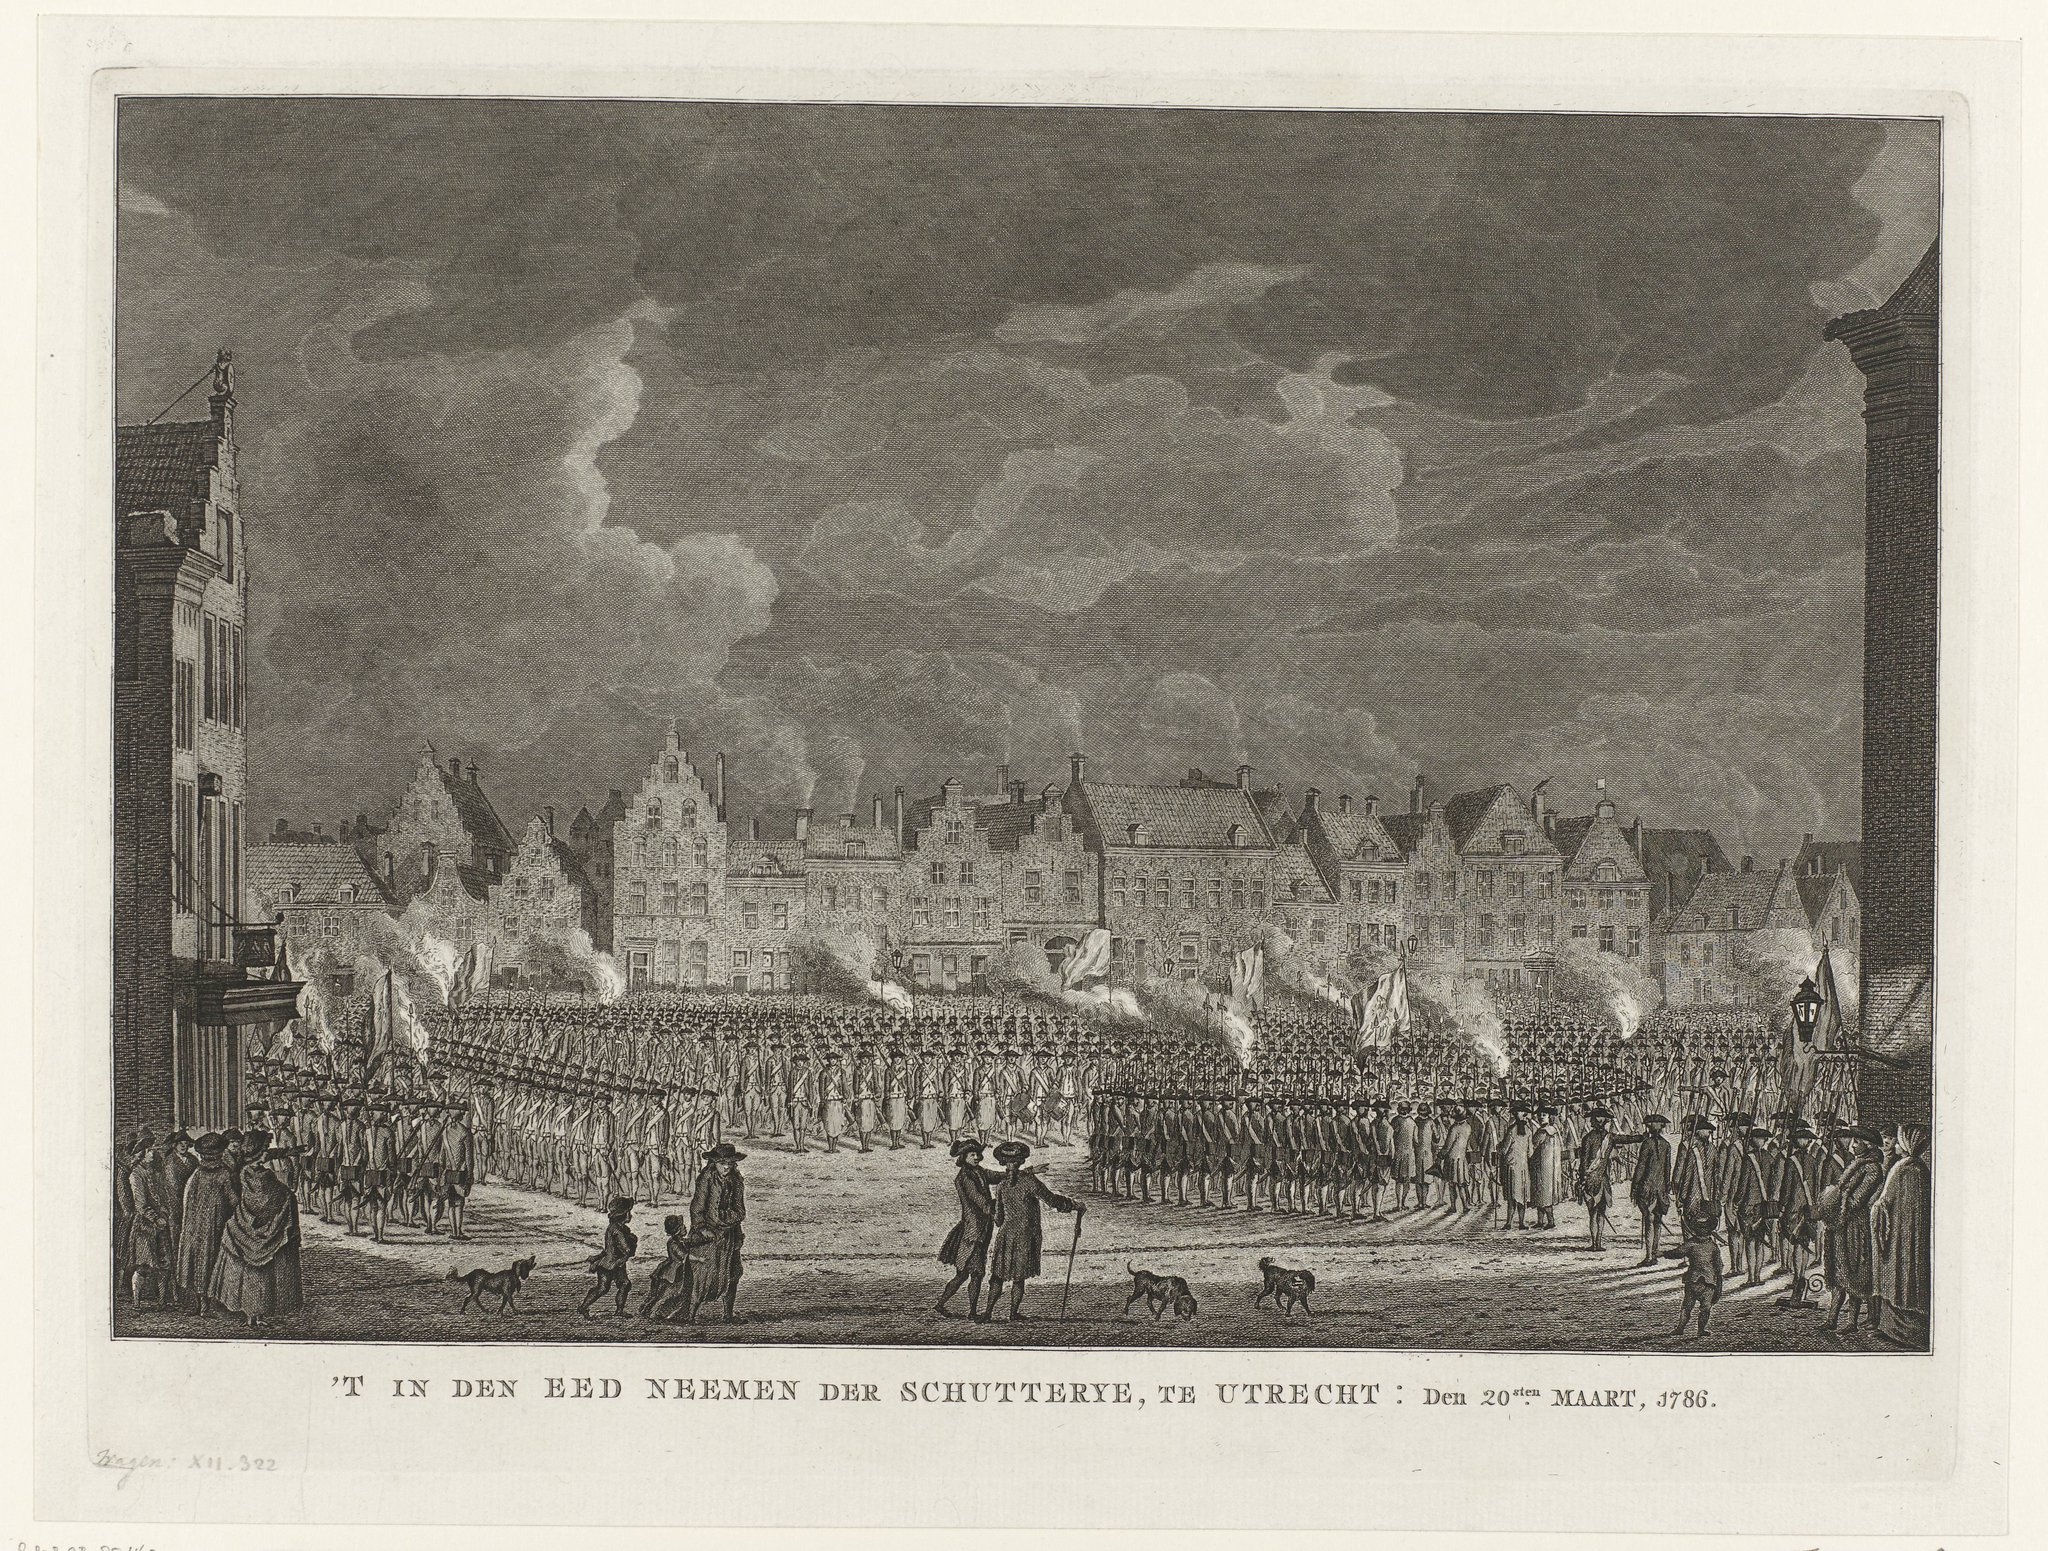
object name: print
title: 'T in den Eed Neemen der Schutterye, te Utrecht: Den 20sten Maart, 1786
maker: Anonymous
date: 1786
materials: paper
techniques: engraving, etching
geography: northern netherlands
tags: warfare; military affairs (+ citizen soldiery, civil guard, citizen militia), taking the oath ~ military service, patriots (1780-1795)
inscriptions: collector's mark: Lugt 2228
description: De leden van de schutterij van Utrecht leggen de eed af op het nieuwe regeringsreglement, op de Neude te Utrecht, 20 maart 1786.